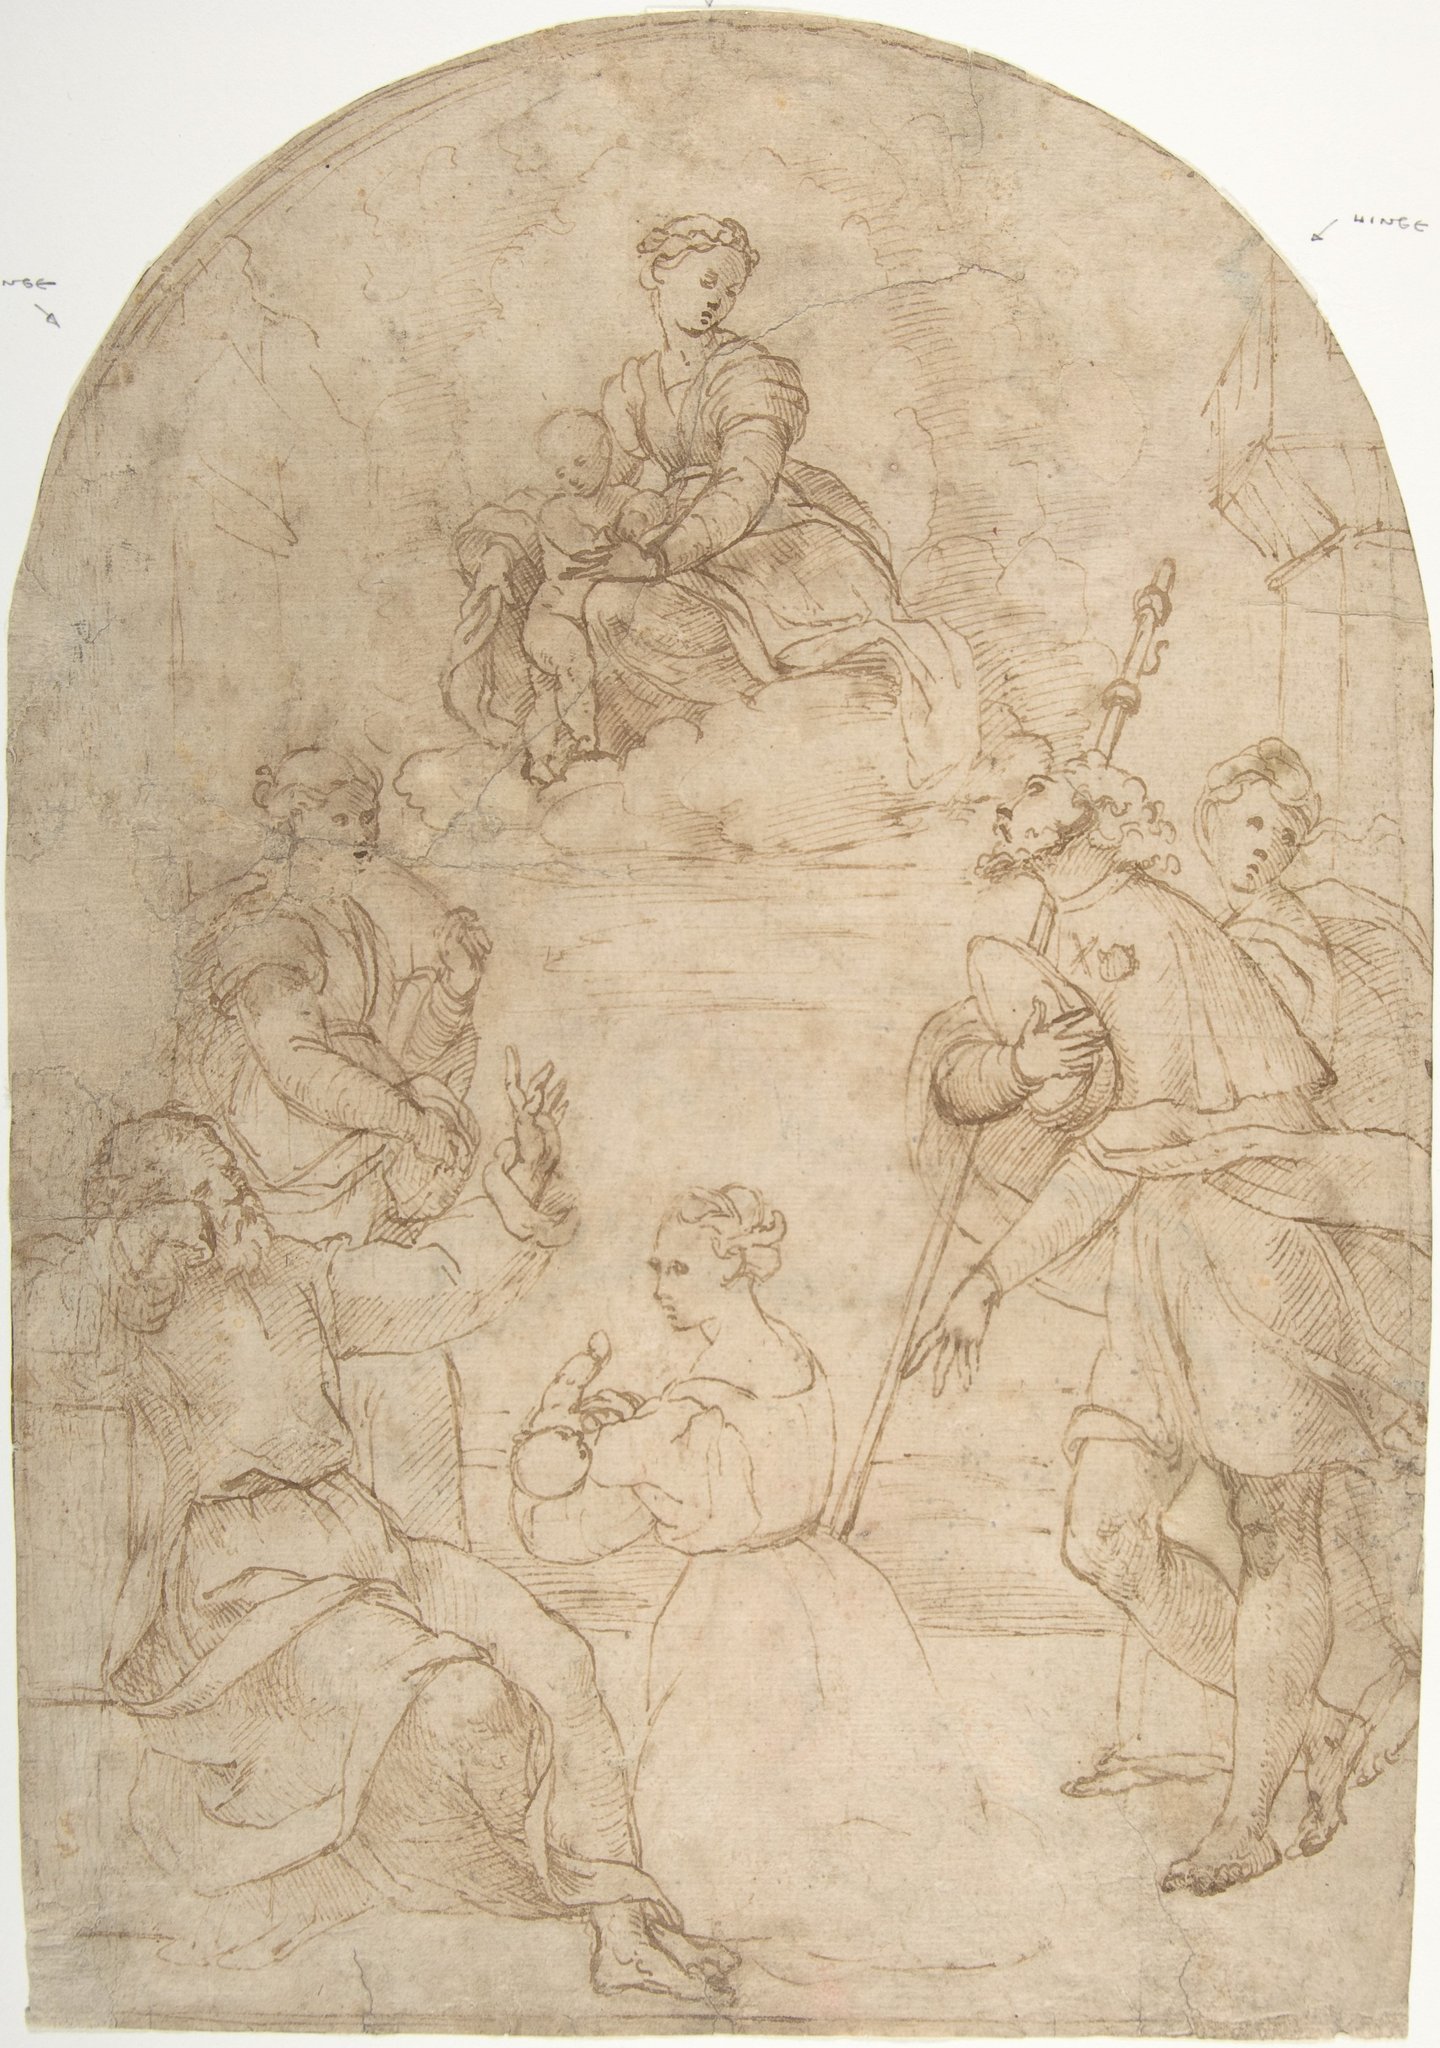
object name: drawing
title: Saint Roch Recommending a Woman with a Sick Child to the Virgin (recto); Figure of a Man Holding a Book; Nude Figure of a Man (verso)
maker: anonymous, italian, 16th century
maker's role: artist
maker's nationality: italian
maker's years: 1550-1600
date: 1501-1600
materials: chalk, ink, paper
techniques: pen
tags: infants,men,women,madonna and child,saints